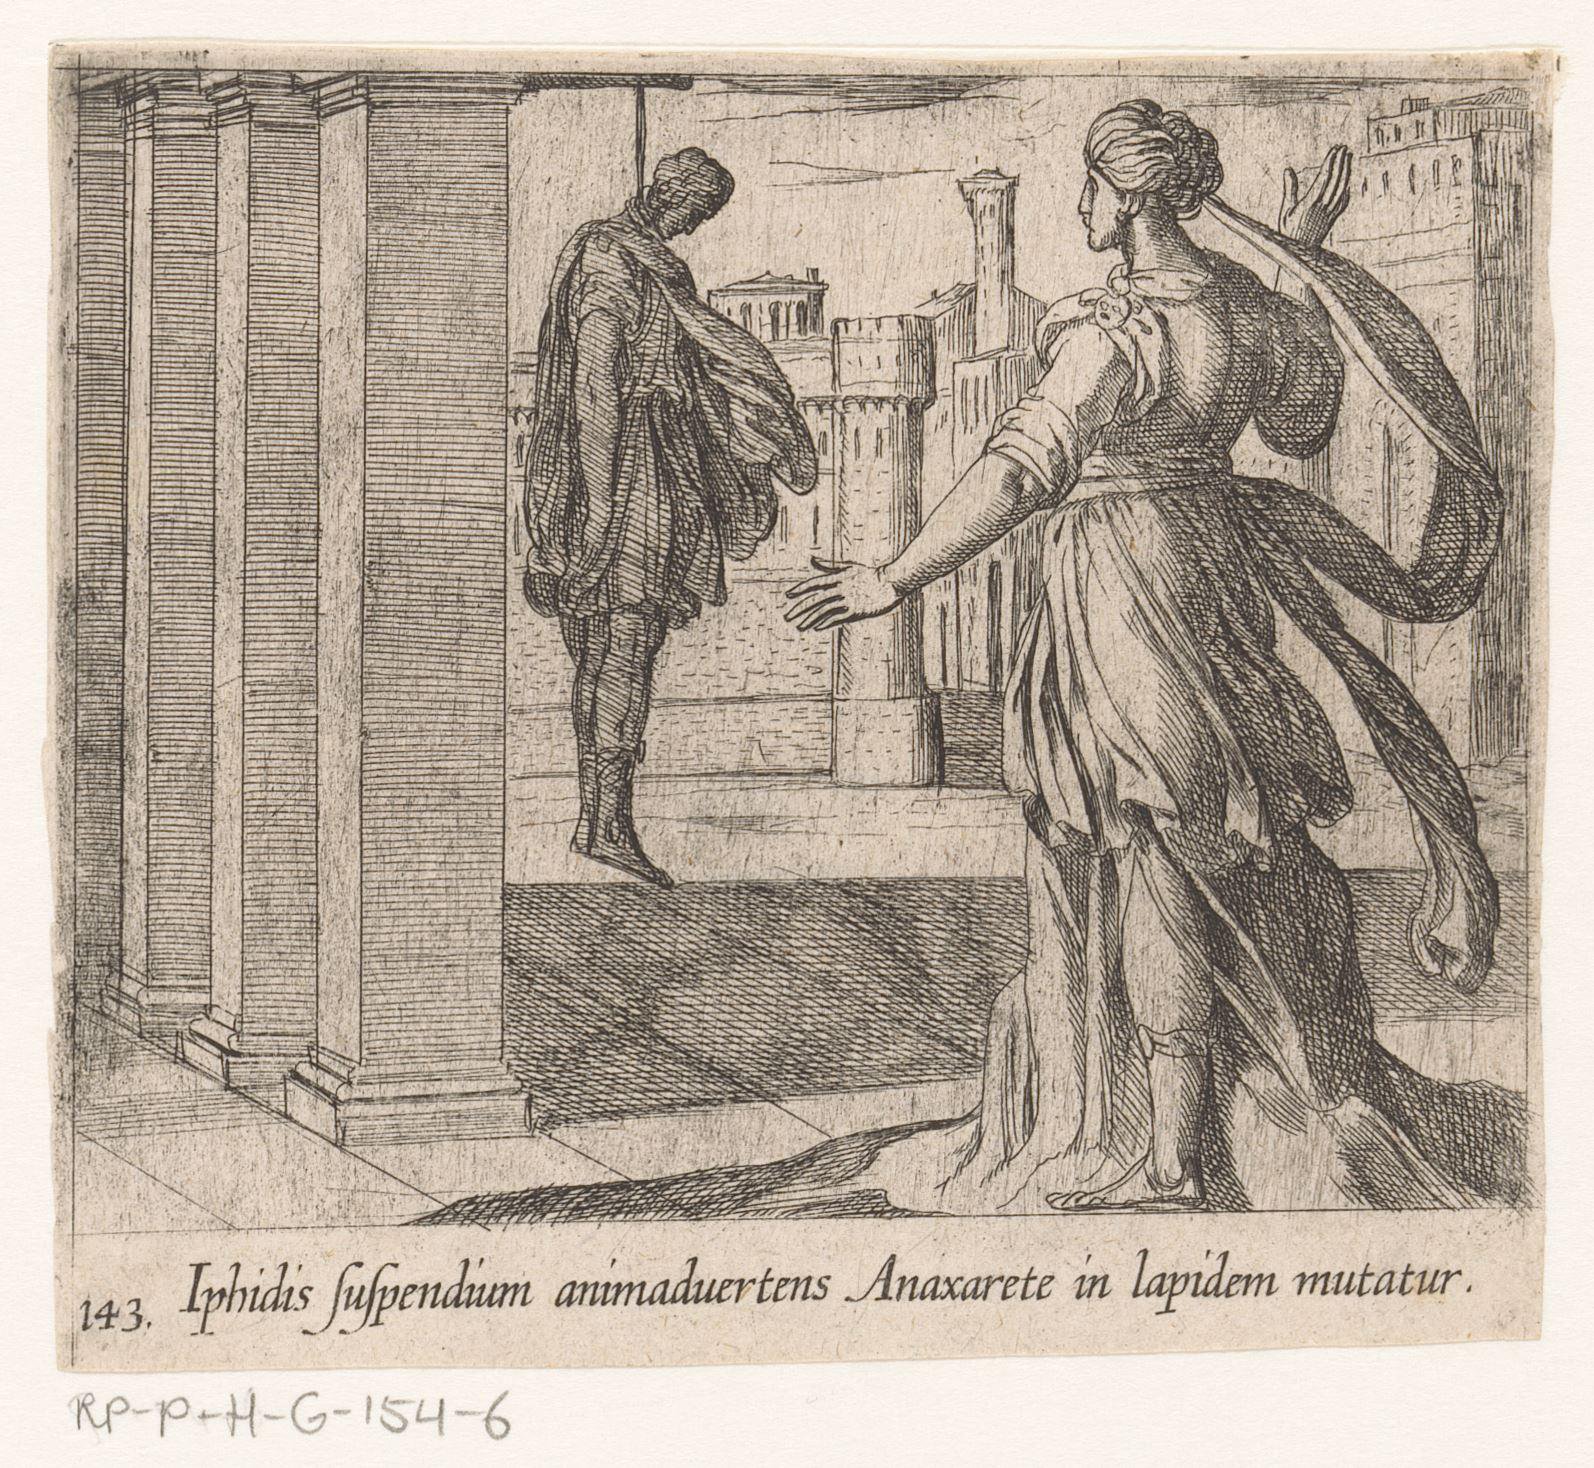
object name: print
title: Metamorphoseon sive transformationum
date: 1606-1638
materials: paper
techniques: etching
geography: italy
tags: death of iphis, a youth of salamis: desperate for the love of anaxarete he hangs himself at her door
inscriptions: collector's mark: ‘Hinloopen’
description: Anaxarete ontdekt het dode lichaam van Iphis, die zich heeft opgehangen voor haar deur. Titel in het Latijn in ondermarge.